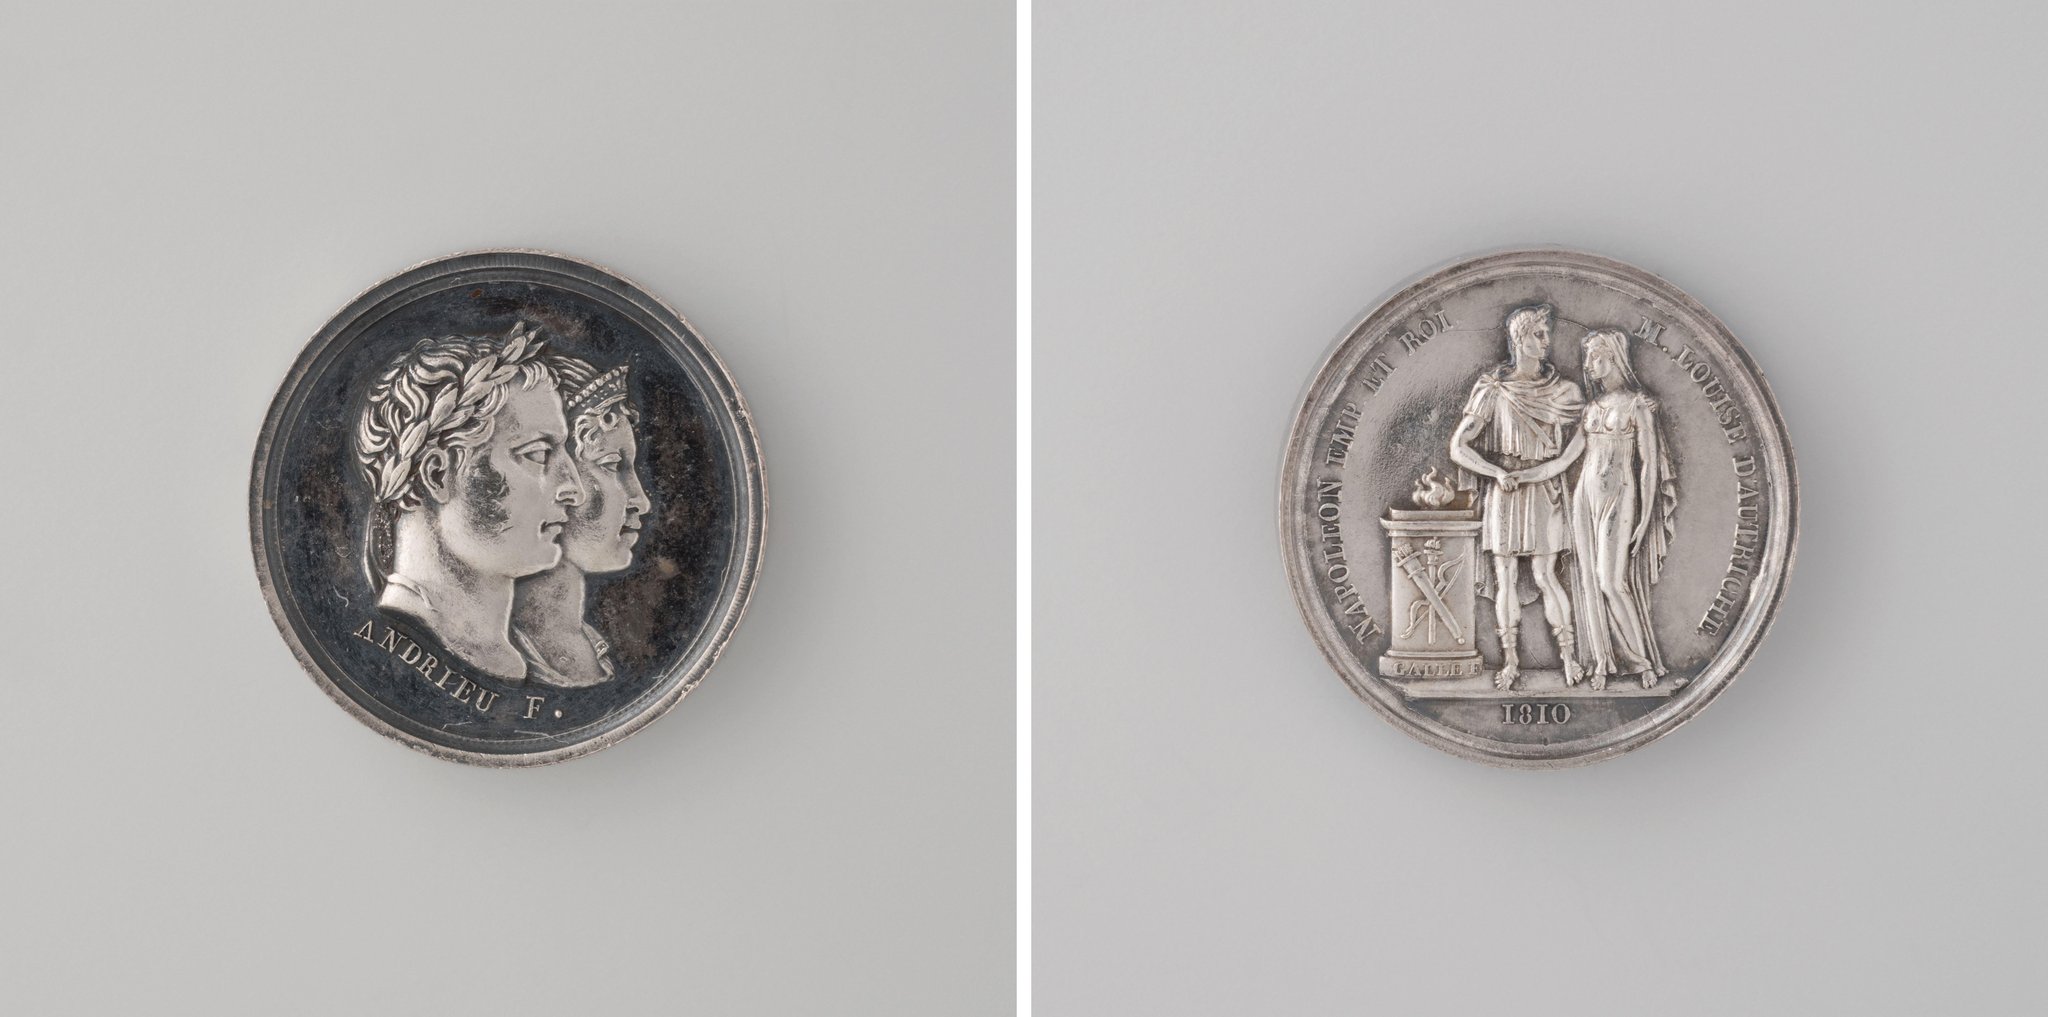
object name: strooipenning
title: Huwelijk van Napoleon I Bonaparte, keizer der Fransen met Marie Louise, aartshertogin van Oostenrijk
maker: bertrand andrieu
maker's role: print maker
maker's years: 1761-1822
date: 1810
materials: silver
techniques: striking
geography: paris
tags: napoleon i (emperor of the french), vienna, marie louise van oostenrijk (keizerin der fransen), paris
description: Zilveren penning. Voorzijde: borststuk man met lauwerkrans en vrouw met diadeem binnen omschrift. Keerzijde: man in Romeinse kledij met lauwerkrans en gesluierde vrouw geven elkaar hand staande voor brandend altaar, waarvan basis is versierd met boog, pijlenkoker en brandende fakkel binnen omschrift; afsnede: jaartal